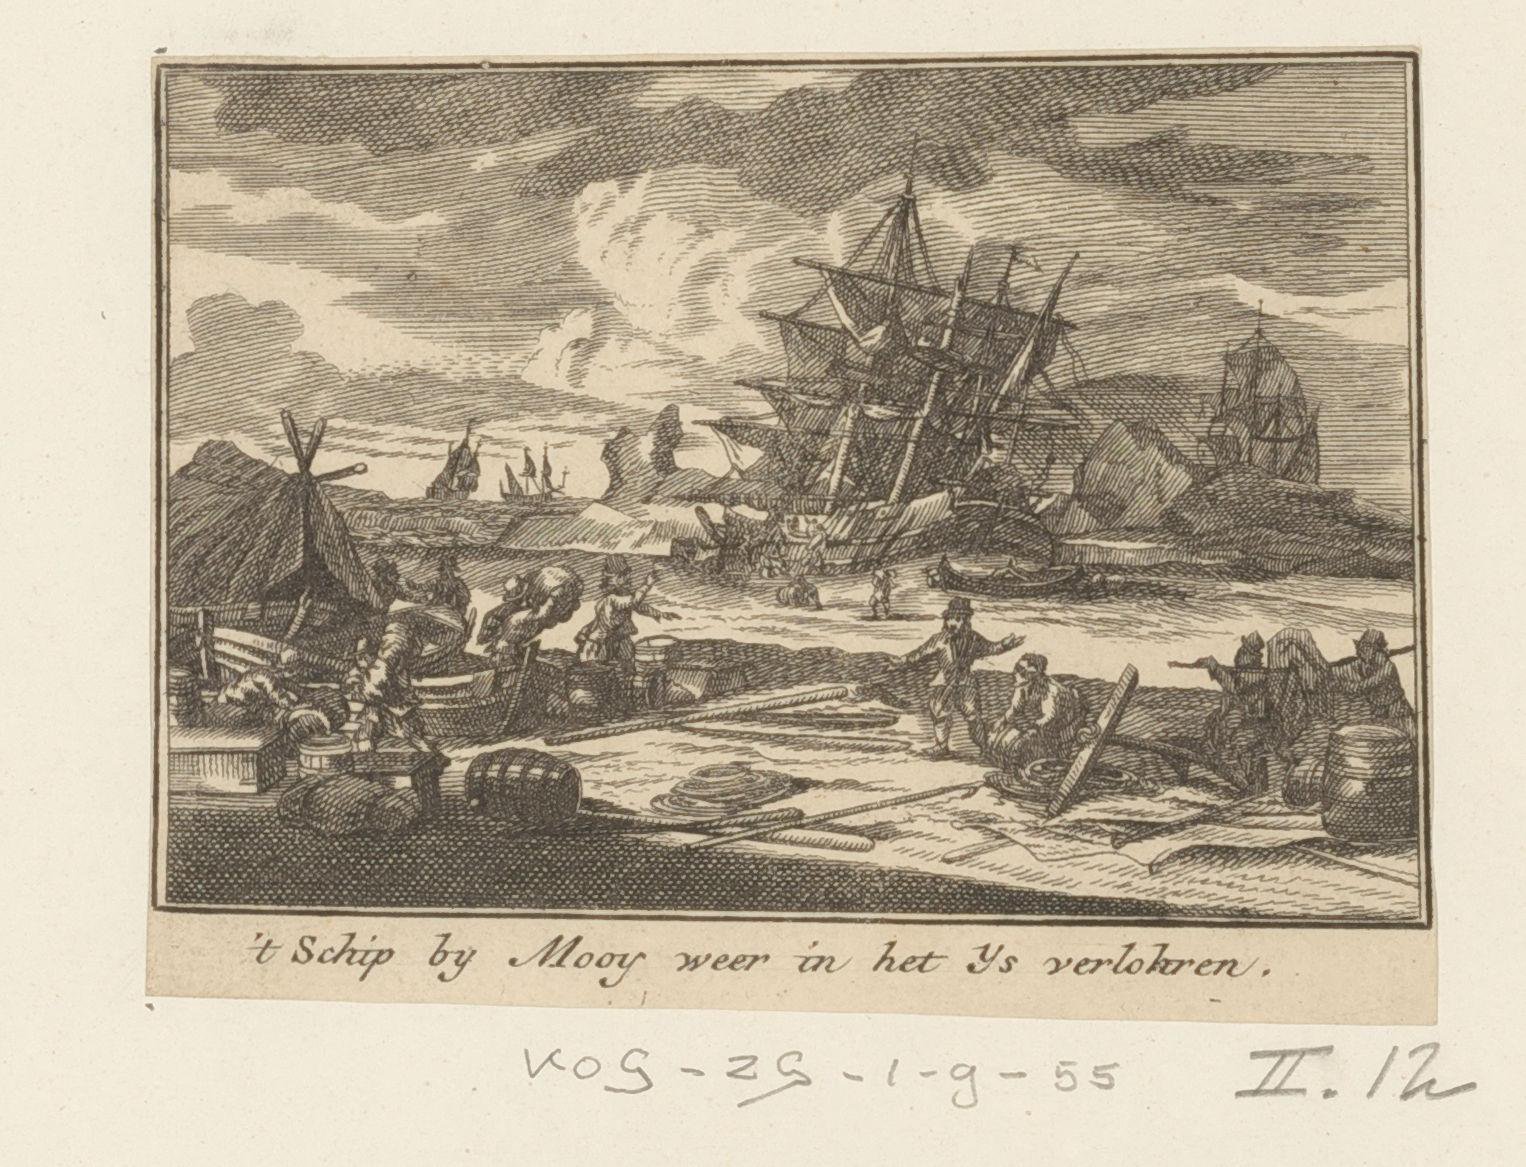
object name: print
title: 't Schip by Mooy weer in het IJs verlohren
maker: Anonymous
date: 1720-1770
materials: paper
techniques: engraving, etching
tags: shipwreck, whale fishery, whaling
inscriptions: stamp, collector's mark: Lugt 1641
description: Prenten zijn een verkleinde versie van de serie Groote Visserij, Visschers Atlas tot Amsterdam. Prenten door Adolf van der Laan, naar tekeningen van Sieuwert van der Meulen en uitgegeven door Pieter Schenk II. De serie bestaat uit zeventien platen over de haringvisserij en zestien platen over de walvisvangst. De serie is waarschijnlijk rond 1720 uitgegeven. De kleine prenten werden met vier voorstellingen op een plaat gedrukt. Elke afbeelding werd genummerd.